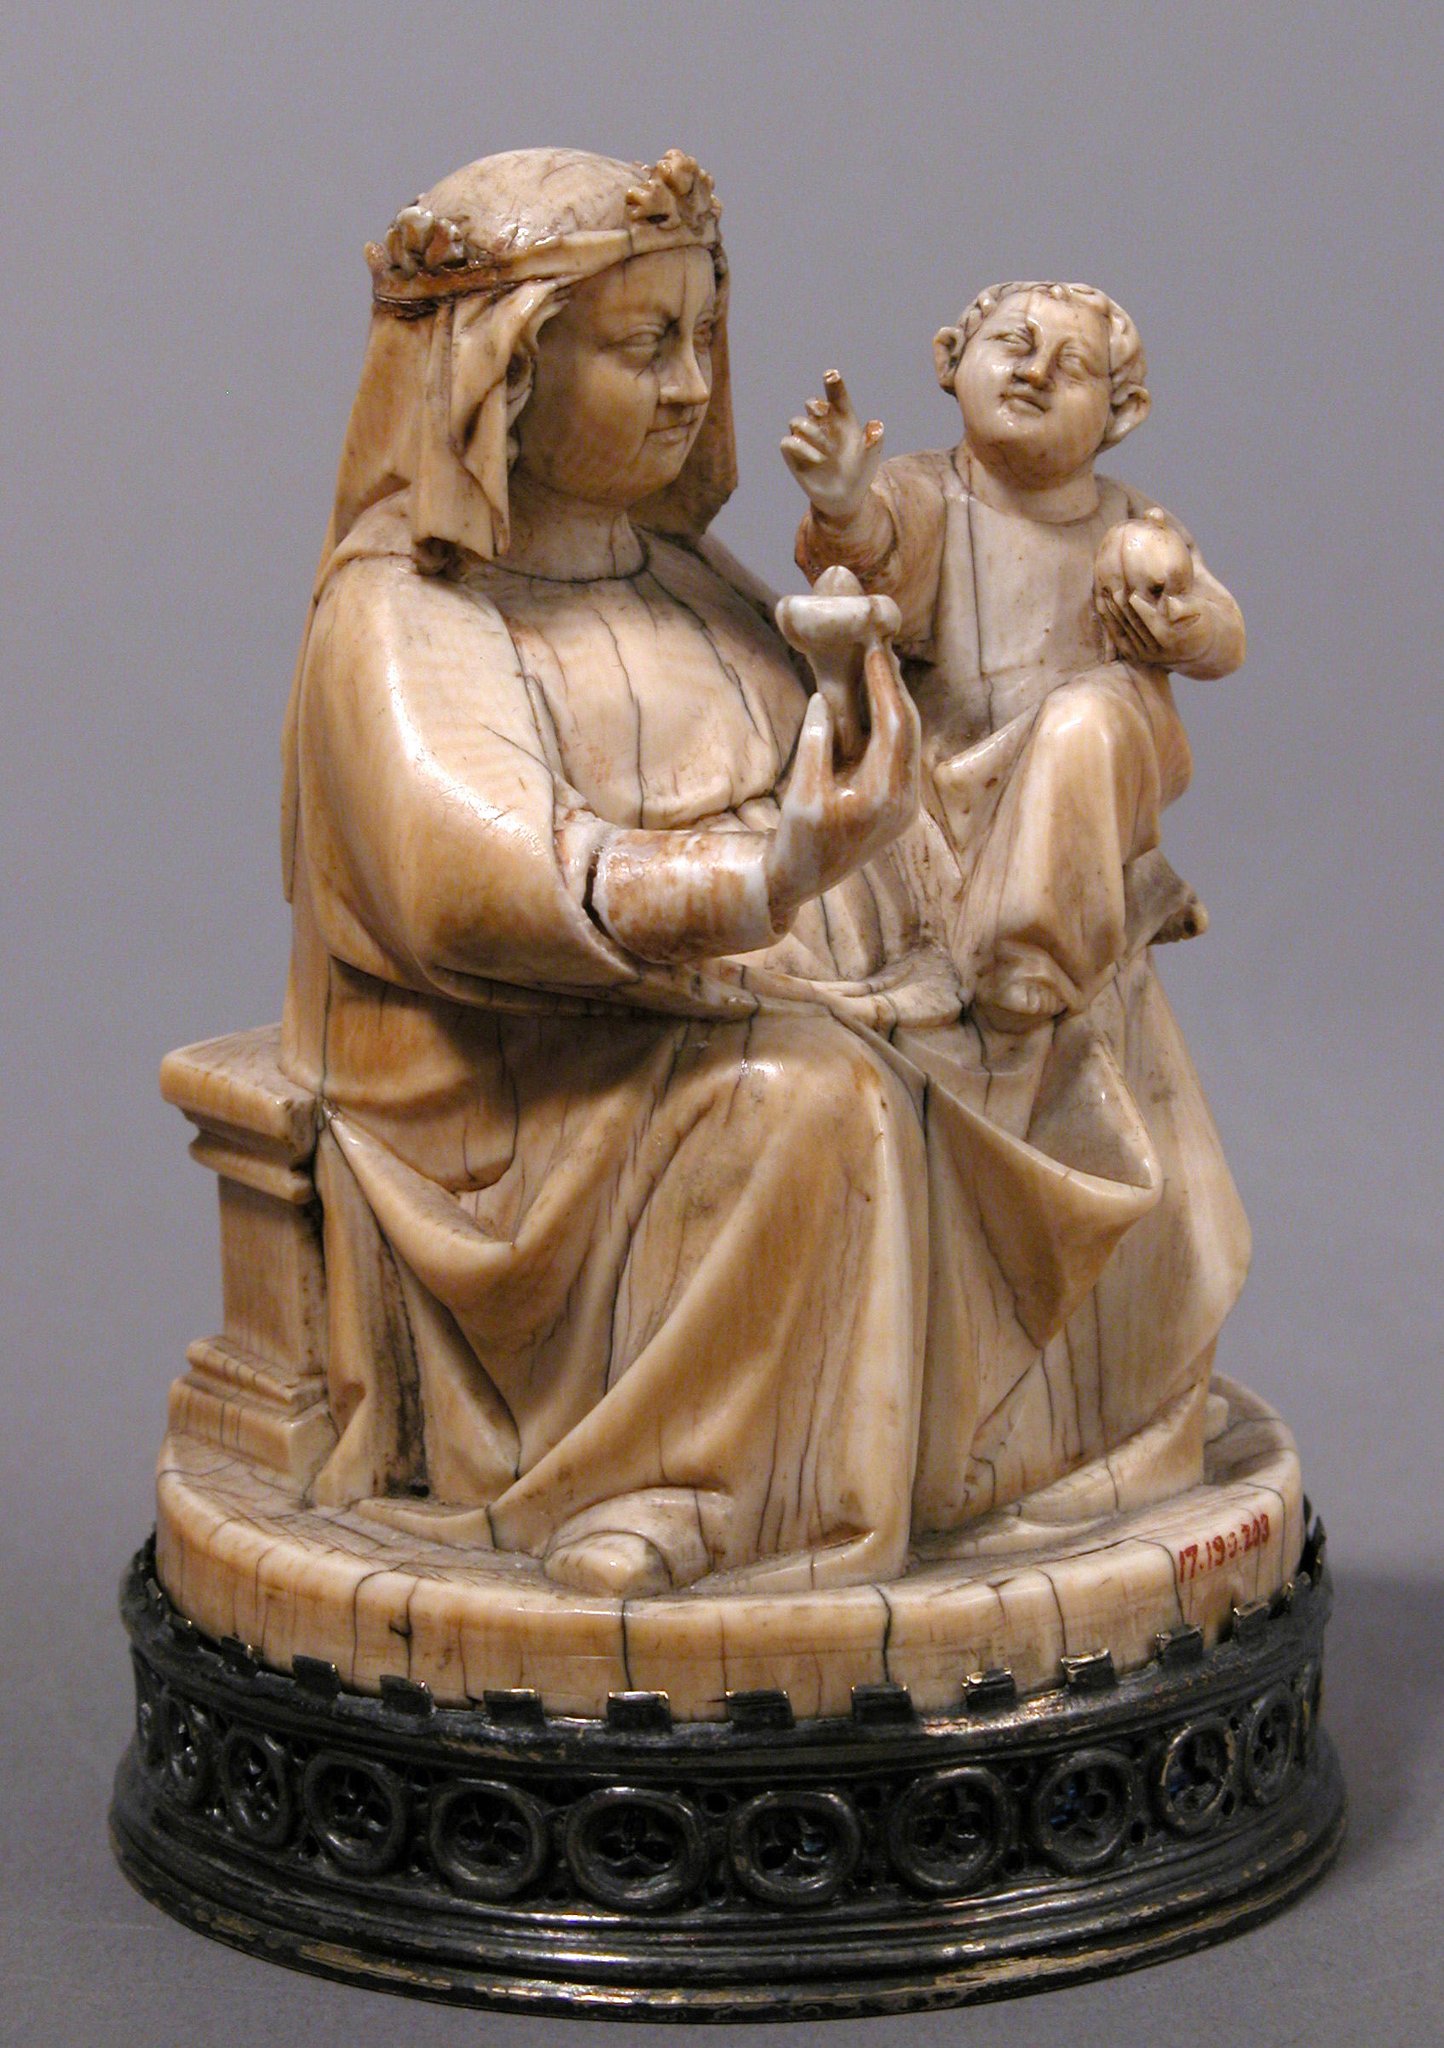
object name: statuette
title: Virgin and Child with an Apple and a Rose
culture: german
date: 1350-1375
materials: enamel, gilt, ivory, silver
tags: apples,roses,madonna and child